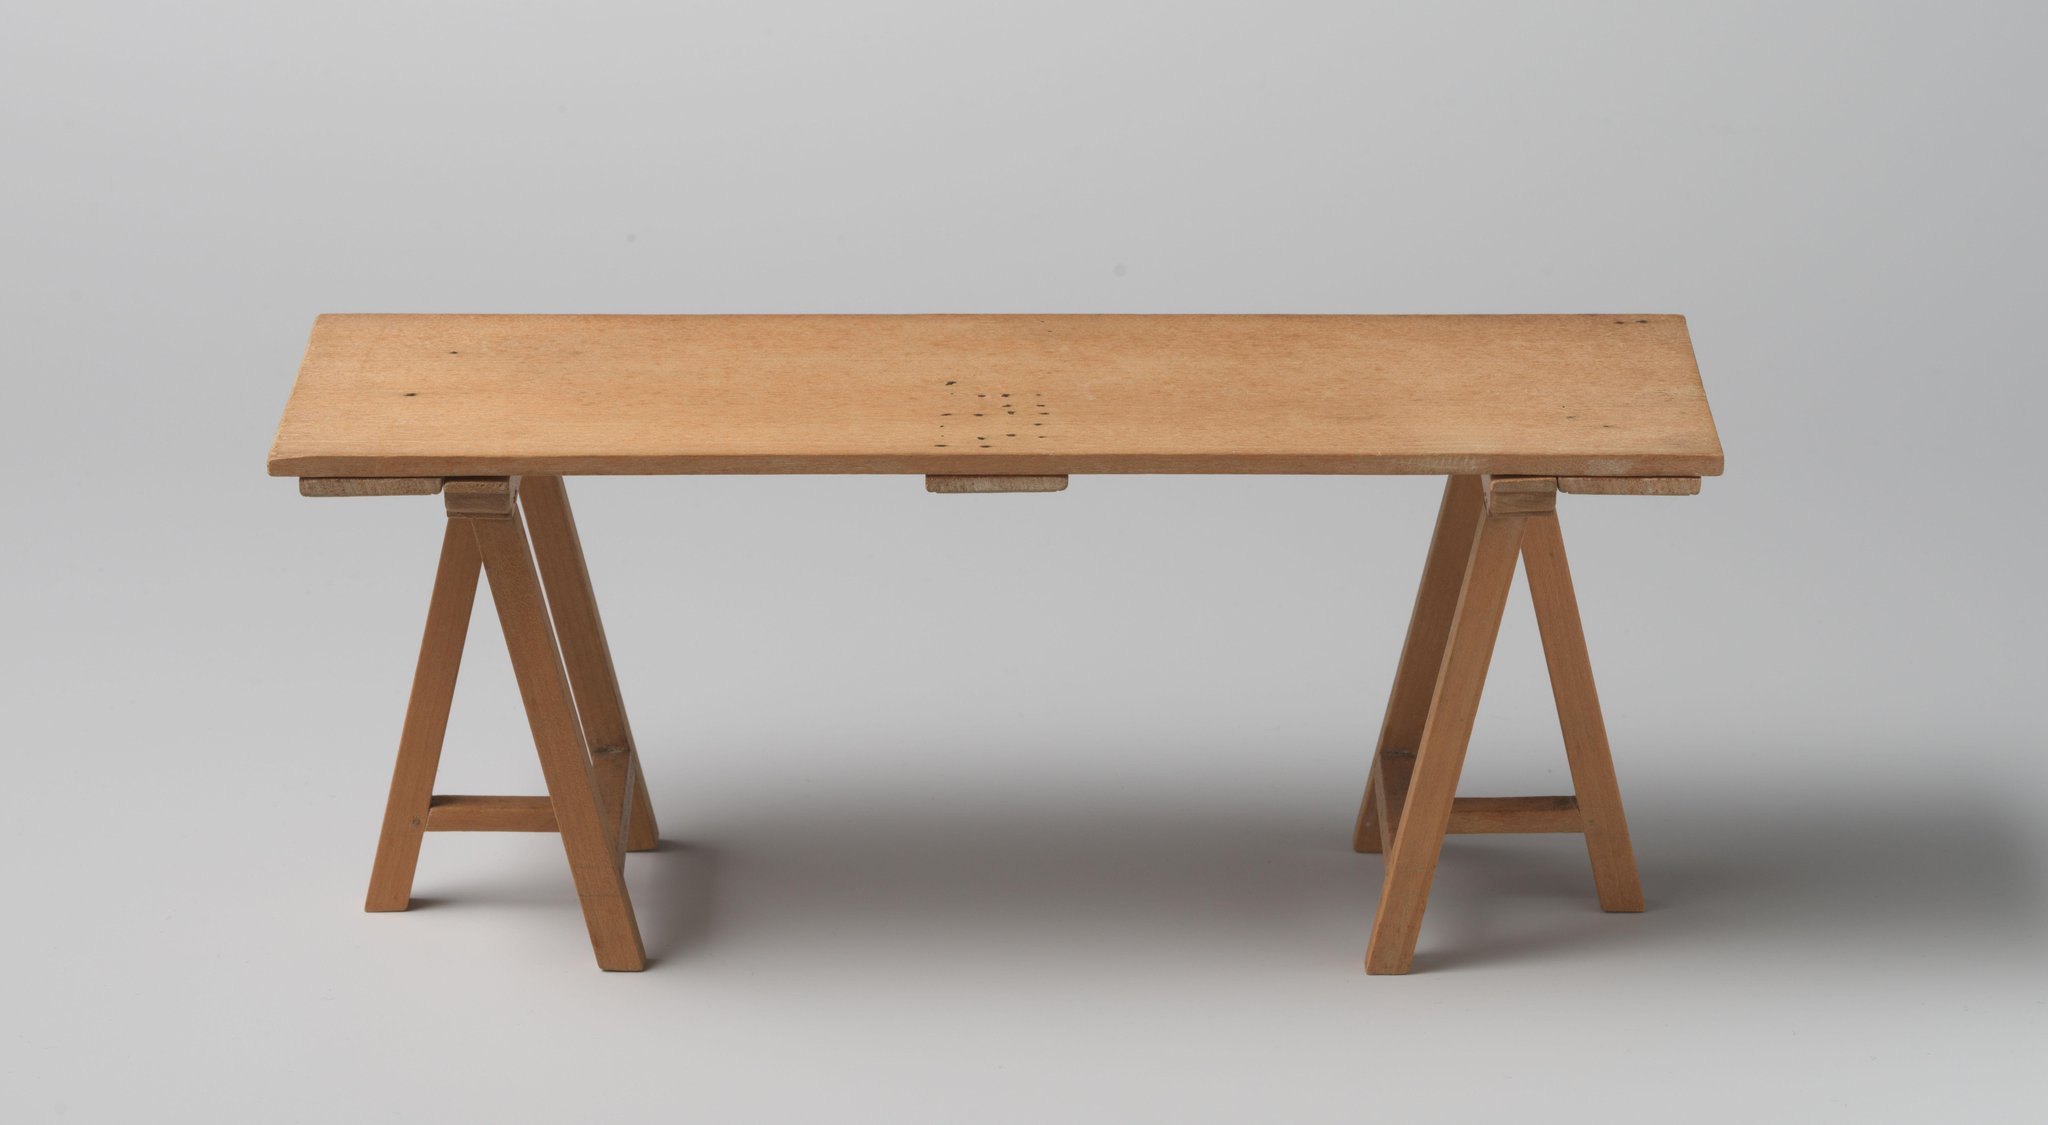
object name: strijktafel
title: Strijktafel, bestaande uit een lang rechthoekig blad op twee schragen.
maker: Anonymous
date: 1690-1710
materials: brass, wood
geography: amsterdam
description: De strijktafel bestaat uit een losliggend blad, de strijkplank, op twee driepotige schragen. Het blad is zeer gedetailleerd geconstrueerd. Om kromtrekken te voorkomen is het blad aan de onderzijde vertevigd met drie dwarsdelen, vastgezet met vier rijen van steeds dertien nagels in een strak patroon. De plank is voorzien van een witte afwerklaag. De verbindingen van de schragen zijn met houten pennen verankerd.